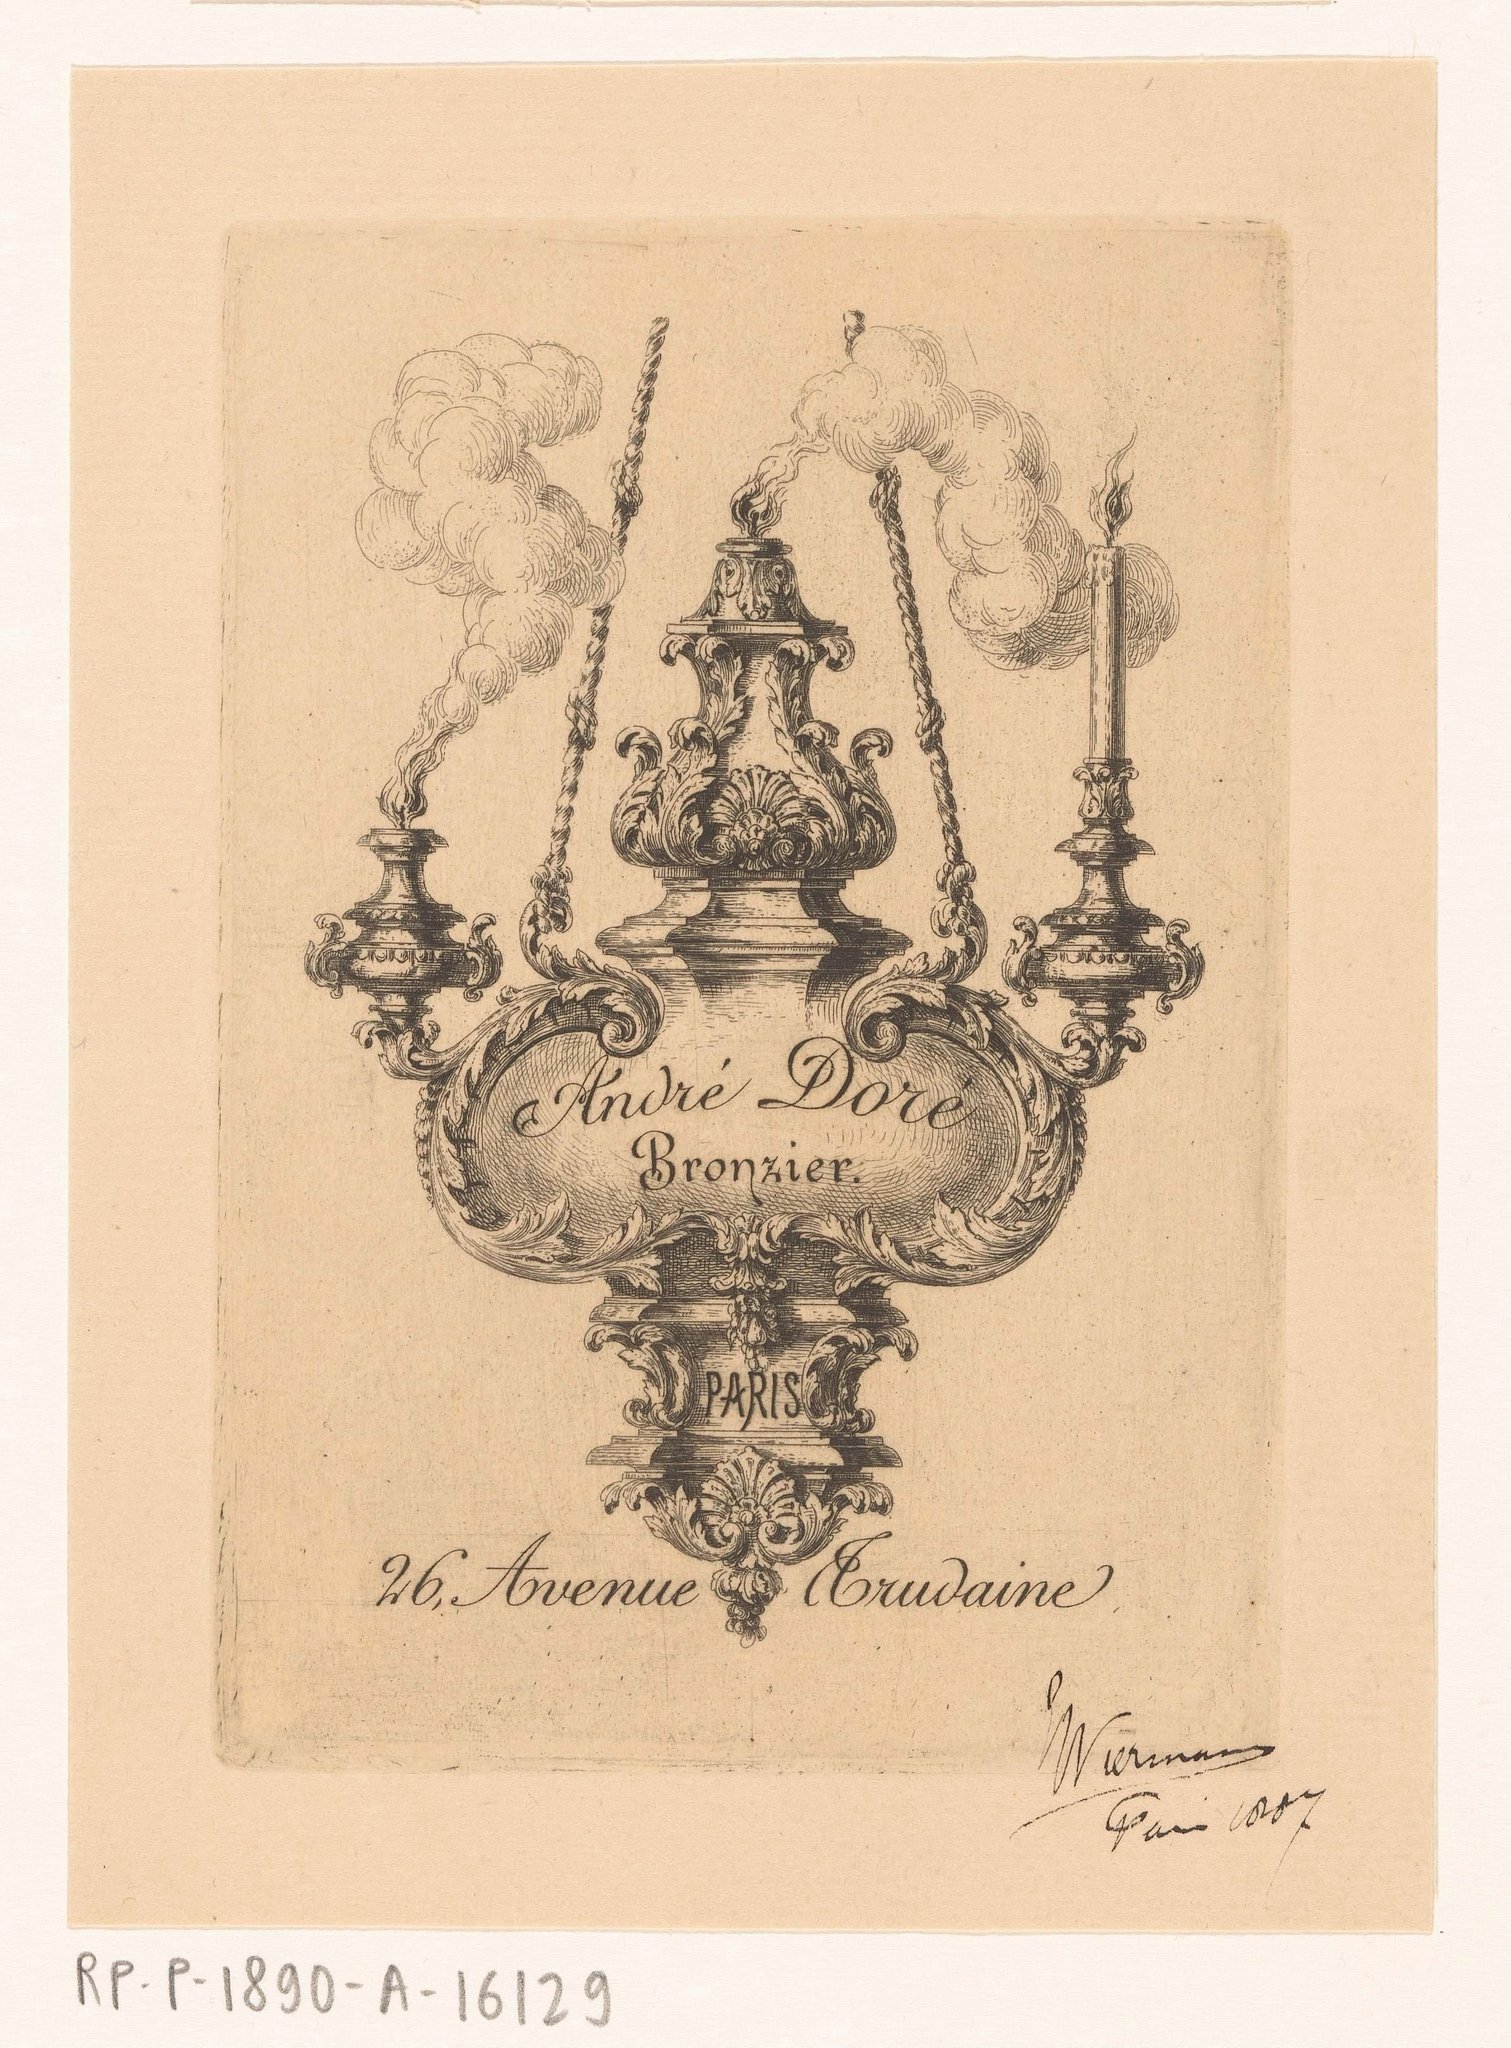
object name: print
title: Adreskaart voor André Doré, vervaardiger van bronzen kunstvoorwerpen in Parijs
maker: eduard niermans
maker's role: print maker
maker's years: 1859-1928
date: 1887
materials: paper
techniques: etching, intaglio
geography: paris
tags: chandelier, candelabrum, paris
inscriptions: collector's mark: Lugt 2228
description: Een kroonluchter met daarop de tekst 'André Doré / Bronzier/ Paris / 26 Avenue Trudaine'.